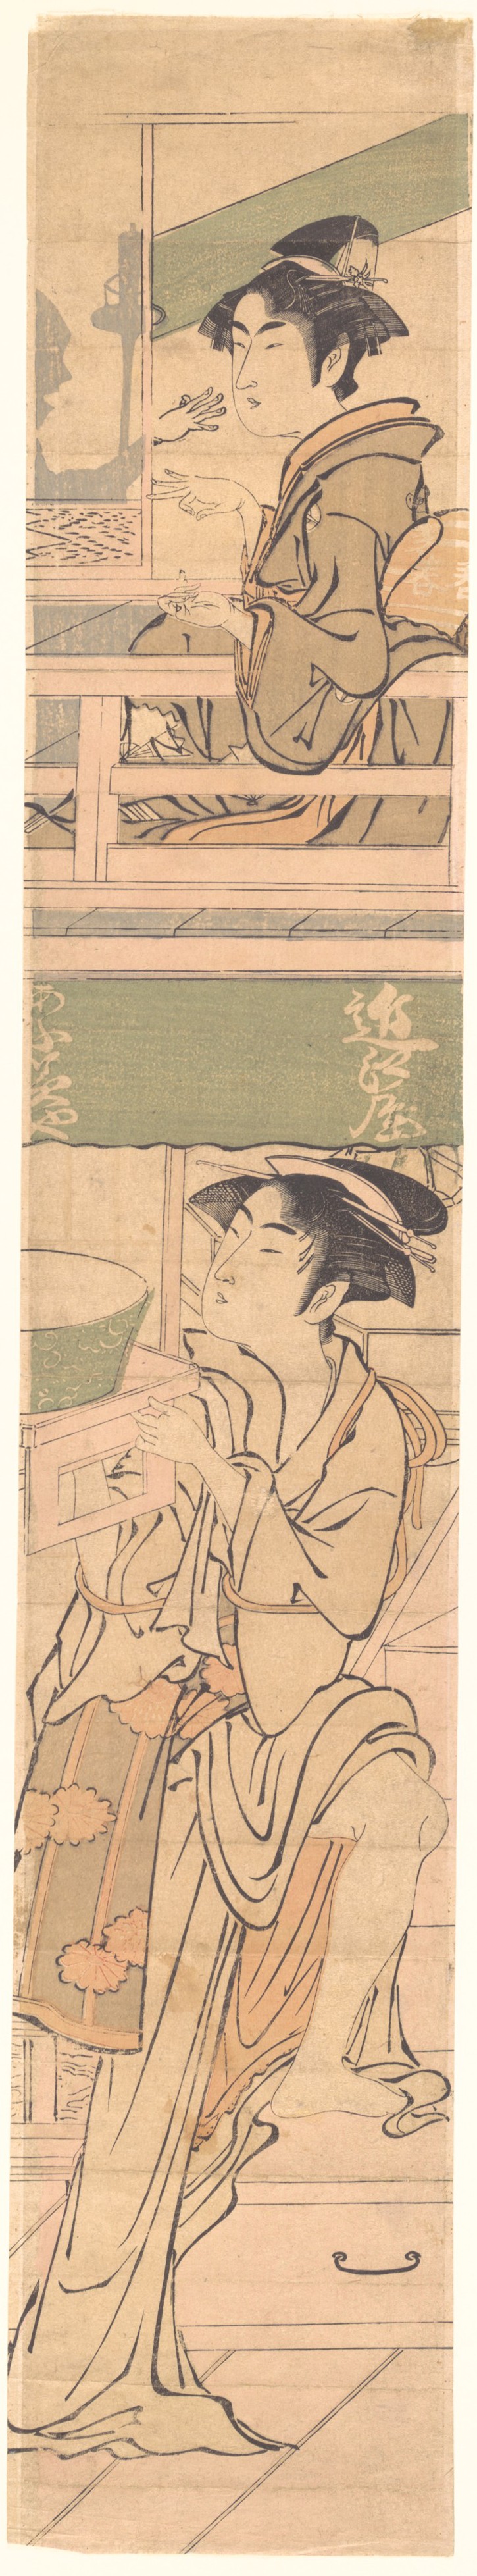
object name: print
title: Two Women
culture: japanese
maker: yumiaki toriyama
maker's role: artist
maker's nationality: japanese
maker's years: 1790-1810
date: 1790-1810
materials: ink, paper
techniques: woodblock print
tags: women